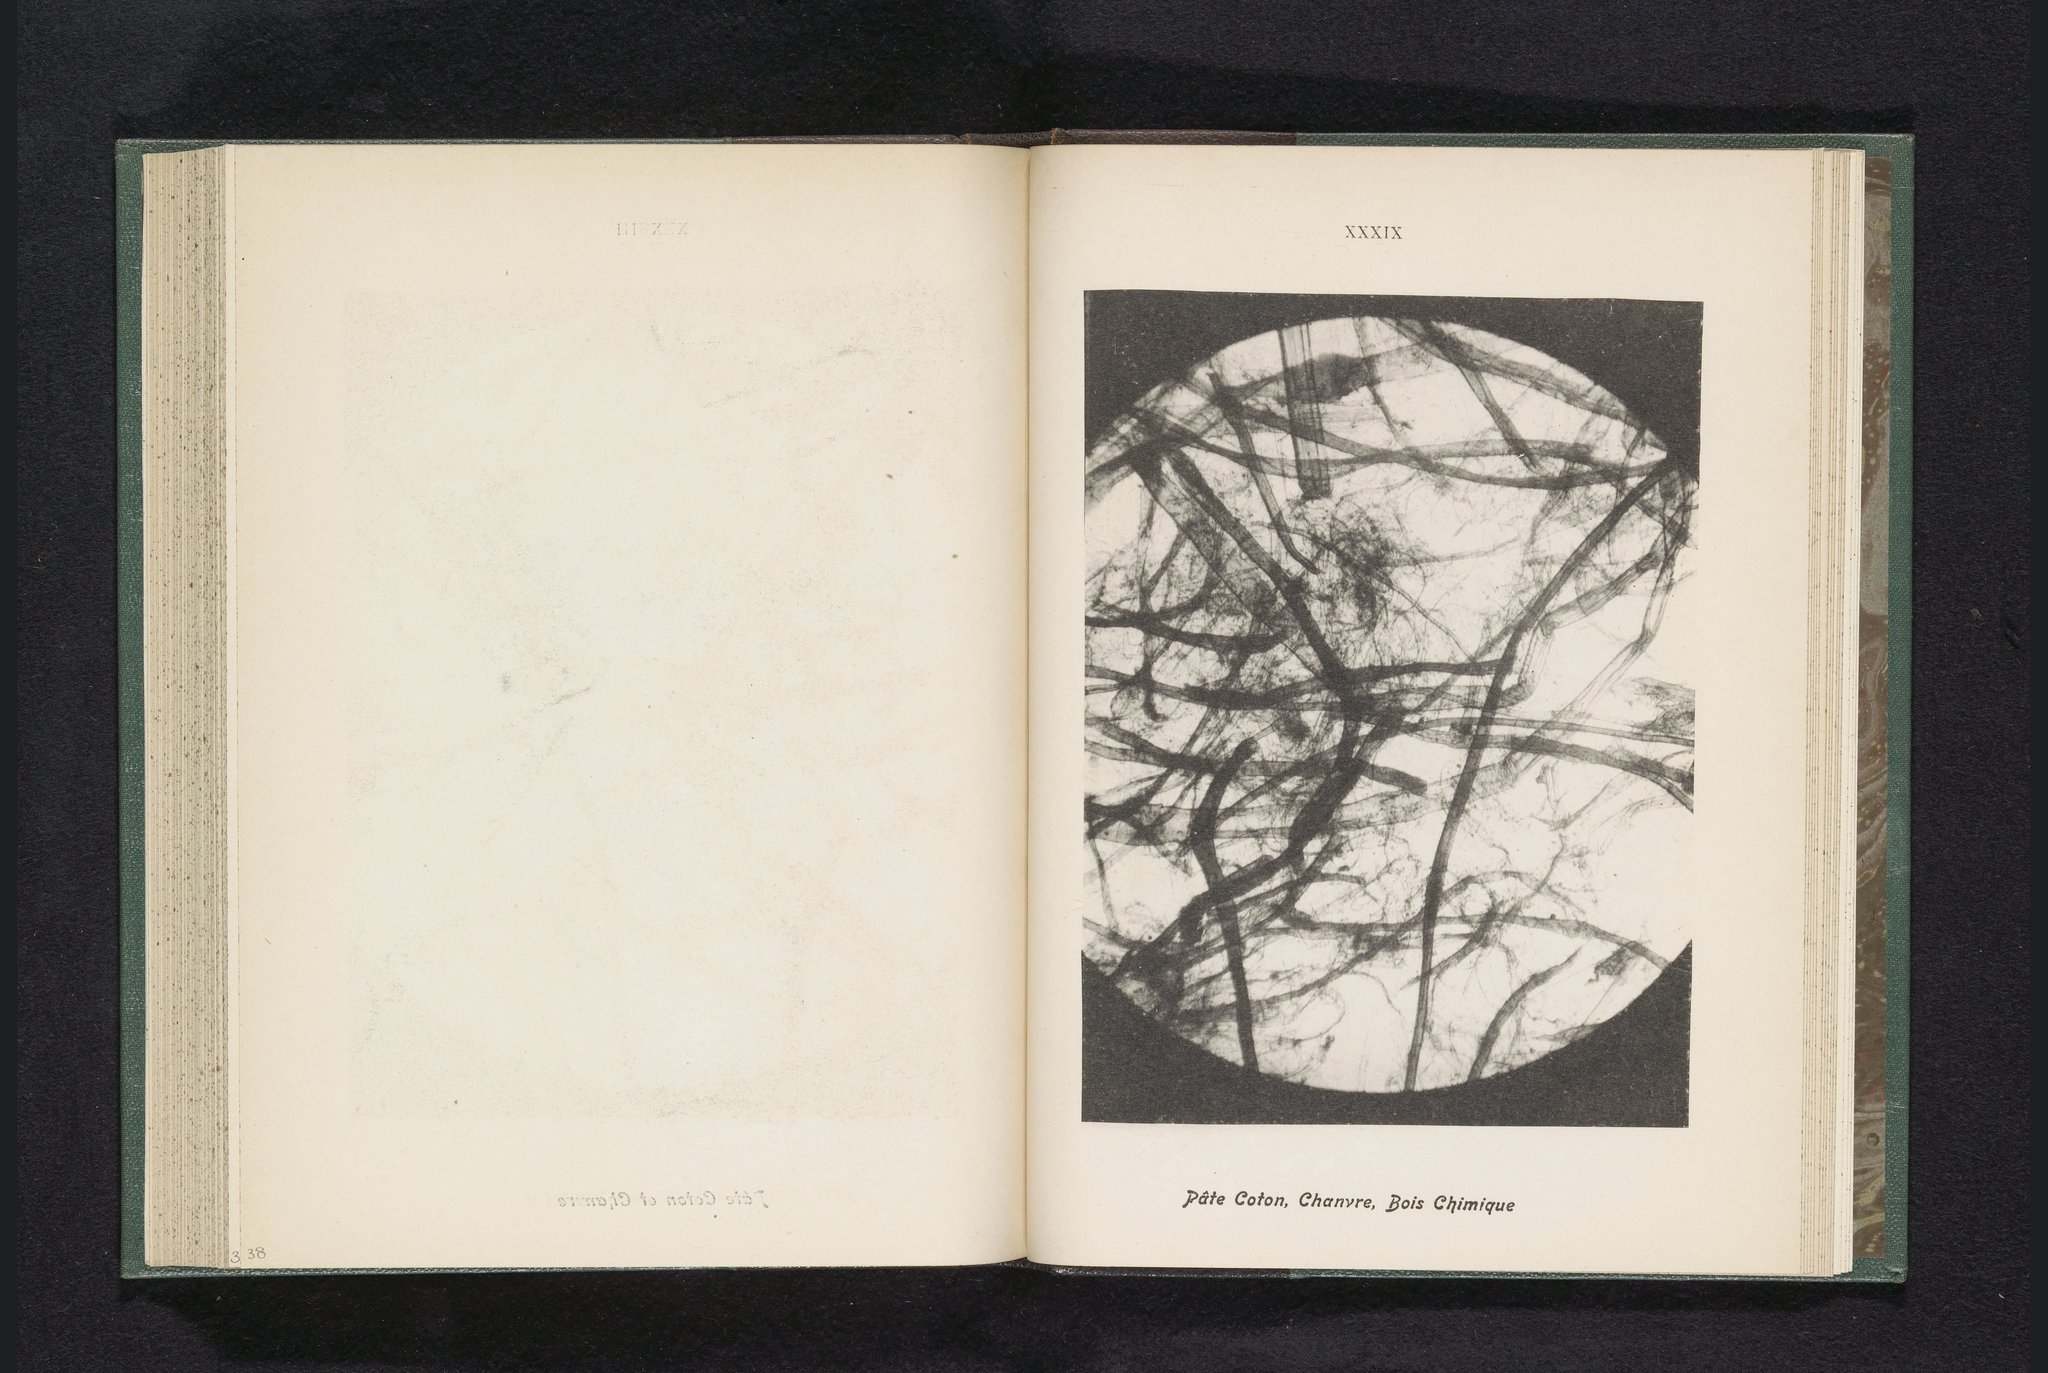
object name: photomechanical print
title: Pâte coton, chanvre, bois chimique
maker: Anonymous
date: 1890-1900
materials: paper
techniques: photograph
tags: cotton (material ~ textile industry)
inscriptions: number: ‘XXXVIX’